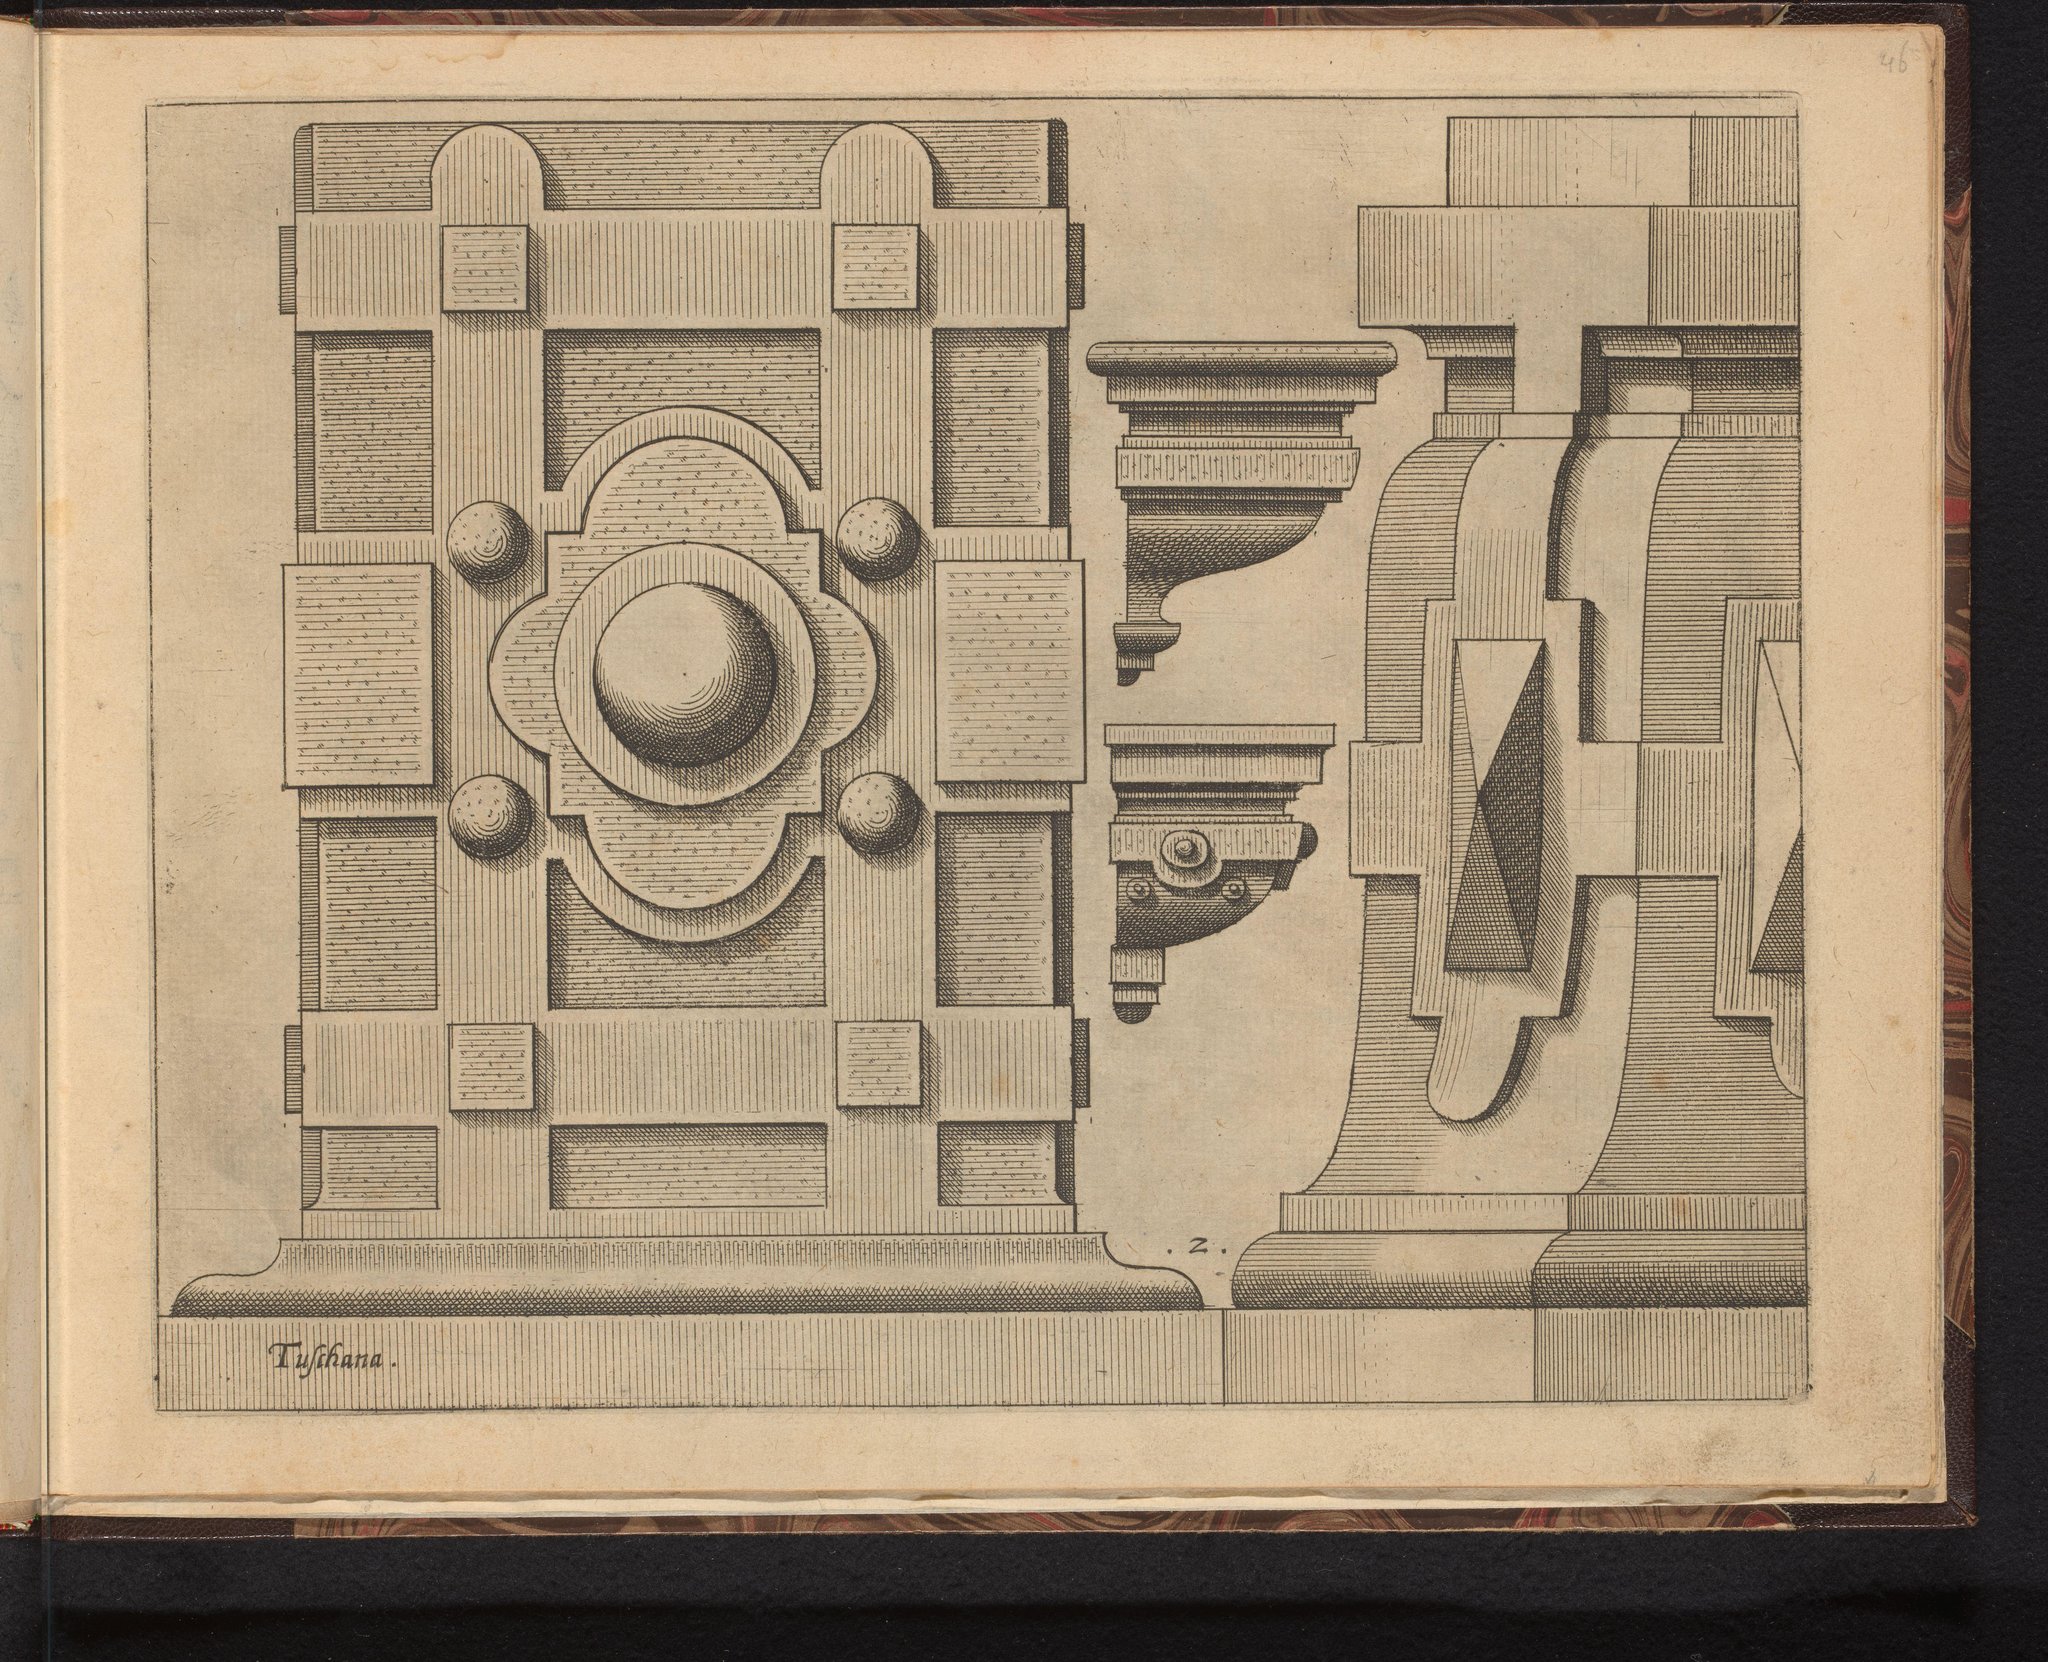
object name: album leaf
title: Architectura de Oorden Tusschana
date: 1578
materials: paper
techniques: etching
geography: antwerp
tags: tuscan order ~ architecture, other architectural details (console), pedestal of a piece of sculpture (perhaps in the form of a herm)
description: Een hele en halve piëdestal en twee consoles. Het linker met rustica en het rechter met diamantkoppen. Daarbij twee consoles. De prent maakt deel uit van een album.